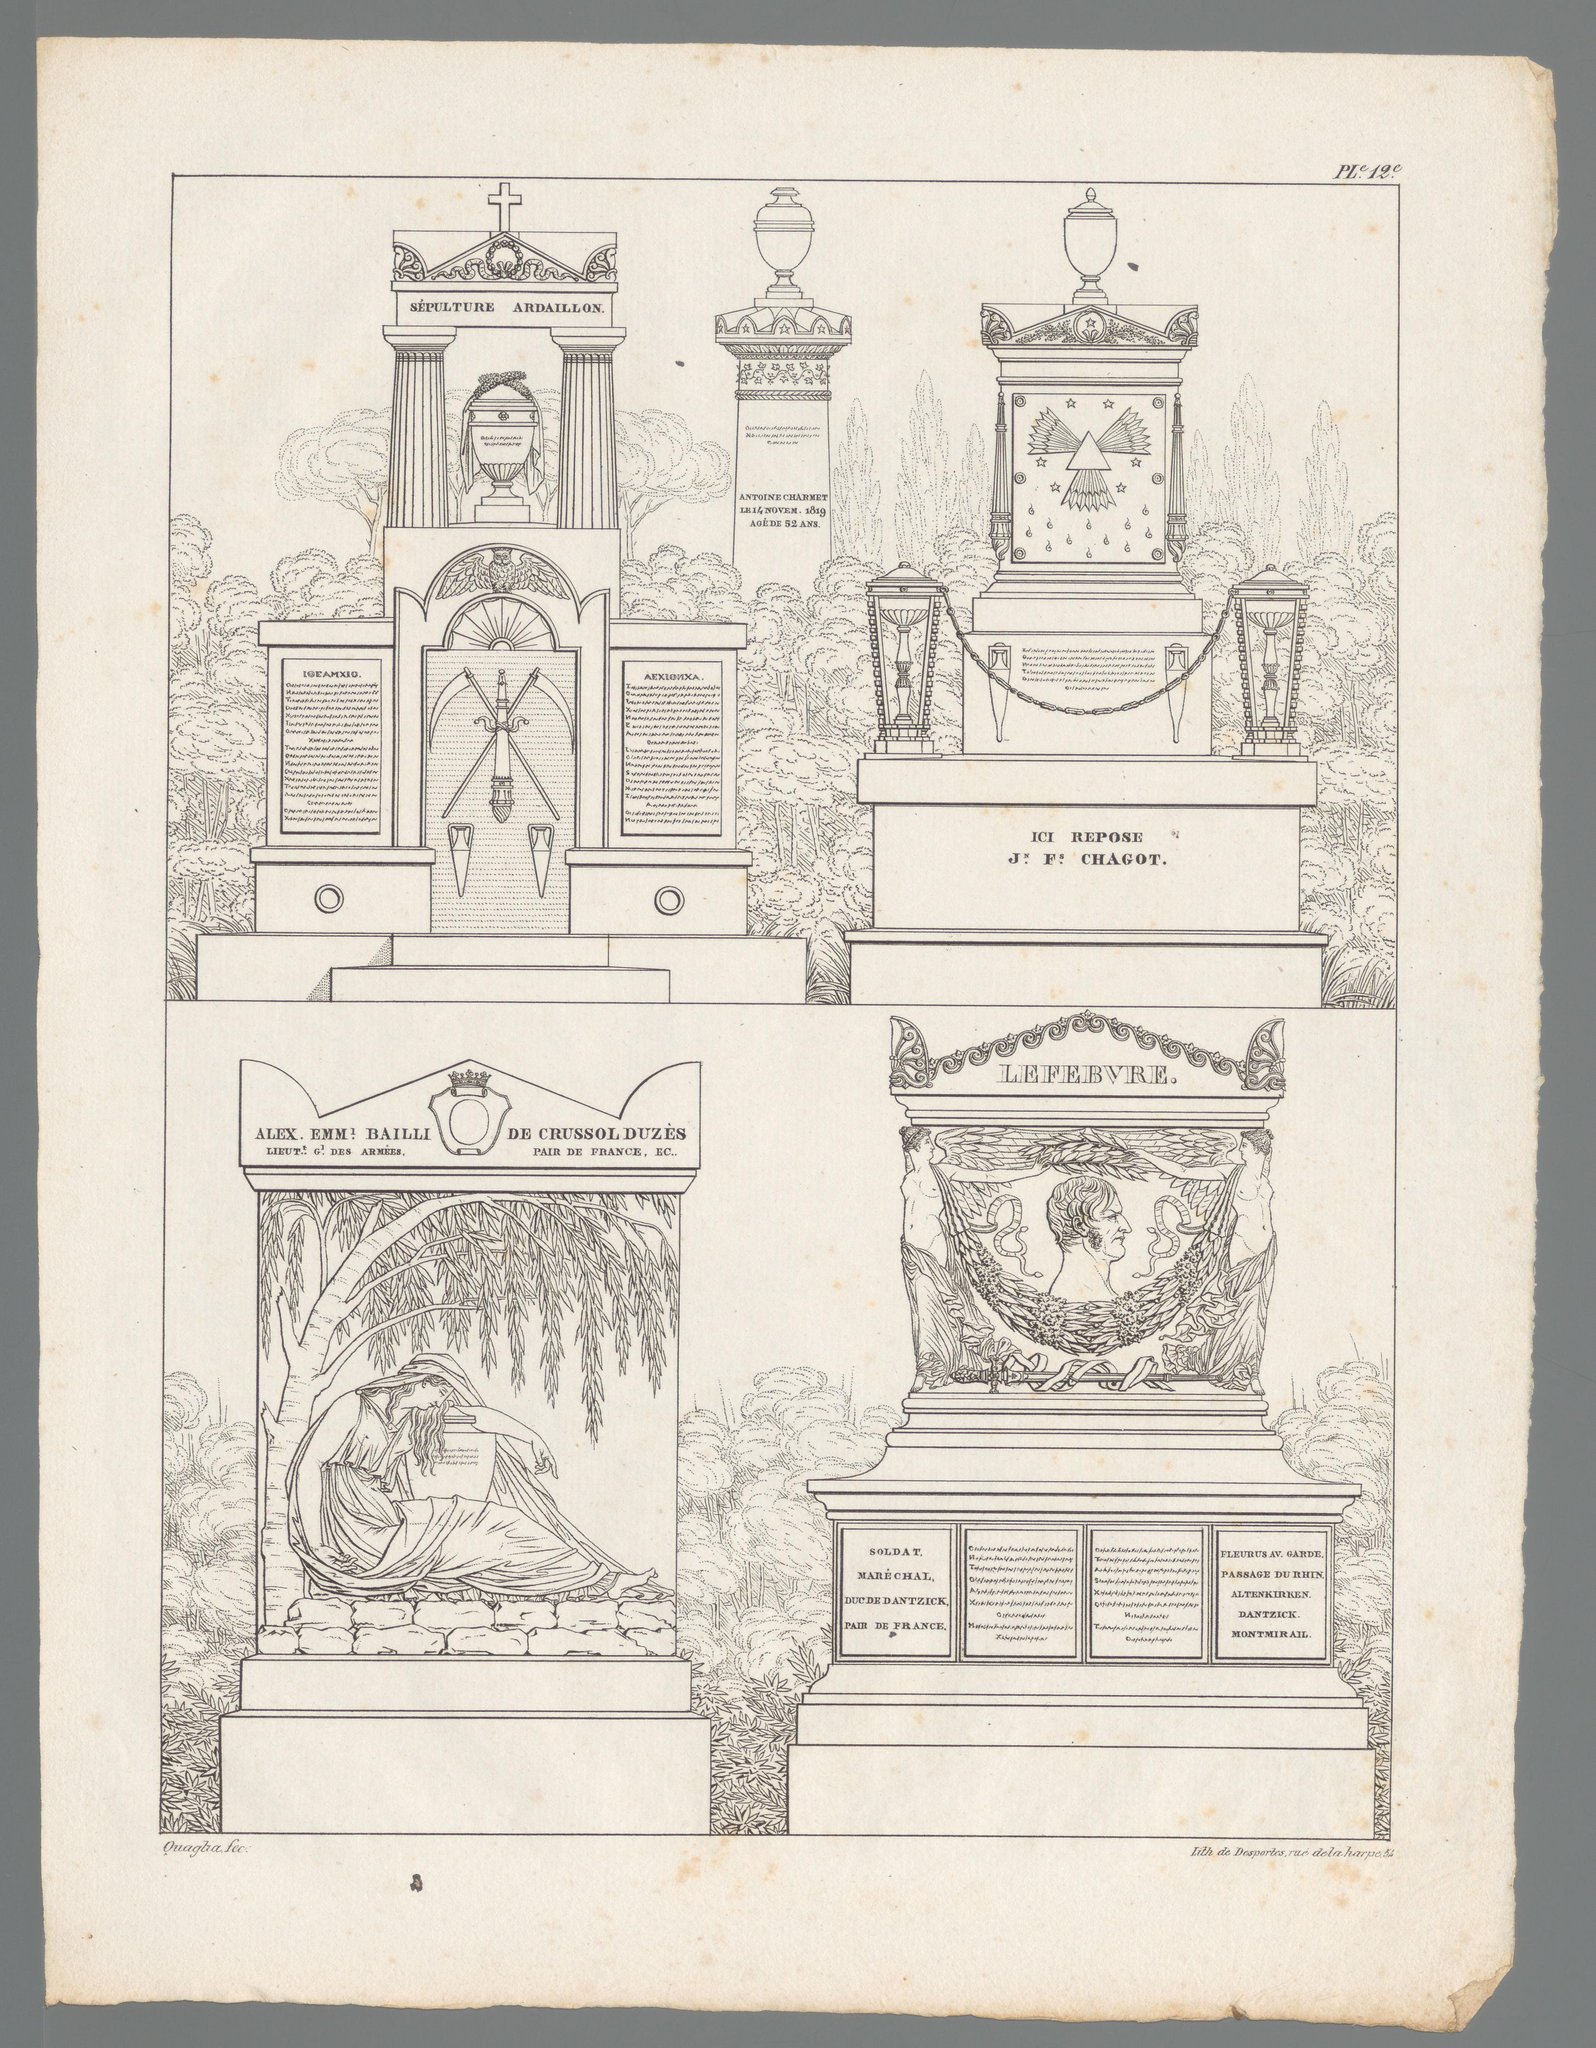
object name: print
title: Gezichten op het Cimetière du Père-Lachaise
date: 1803-1869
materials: paper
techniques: lithograph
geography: paris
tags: cemetery, park-like burying ground